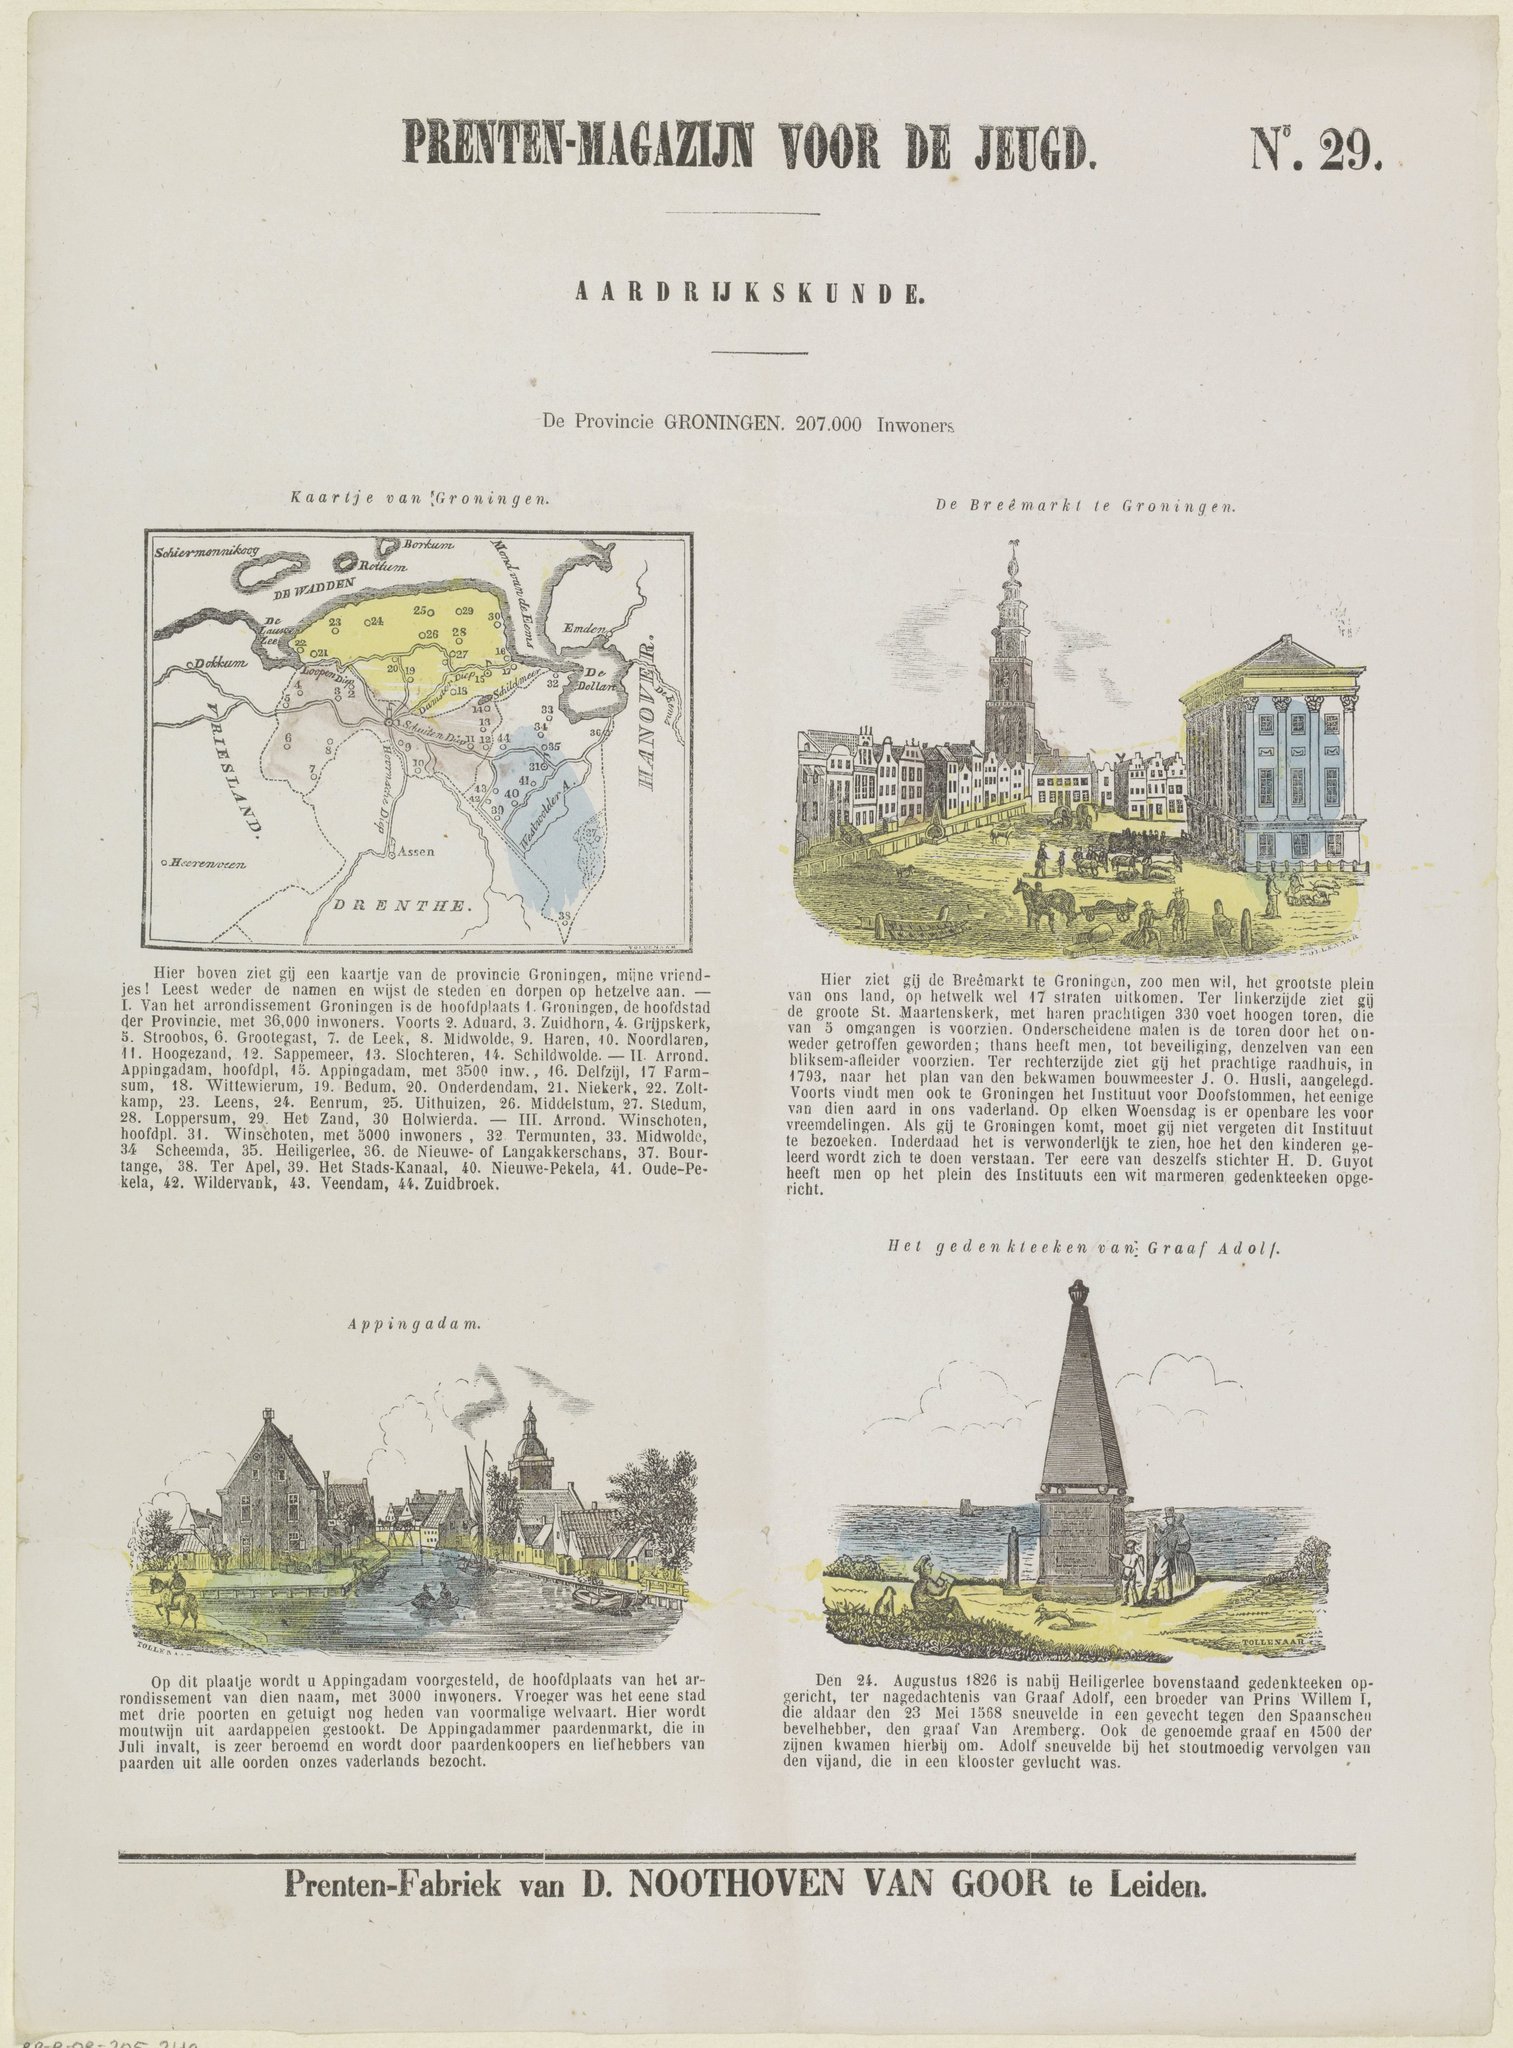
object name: print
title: Aardrijkskunde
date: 1850-1881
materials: paper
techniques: colour, letterpress printing, engraving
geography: netherlands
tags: maps, atlases, monument, statue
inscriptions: collector's mark: Lugt 2760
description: Blad met 4 voorstellingen over de provincie Groningen met een kaart en belangrijke gebouwen en monumenten: de Grote Markt in Groningen, Appingedam en het eerste Graaf Adolfmonument. Boven elke voorstelling een titel en onder elke voorstelling een onderschrift. Genummerd rechtsboven: No. 29.